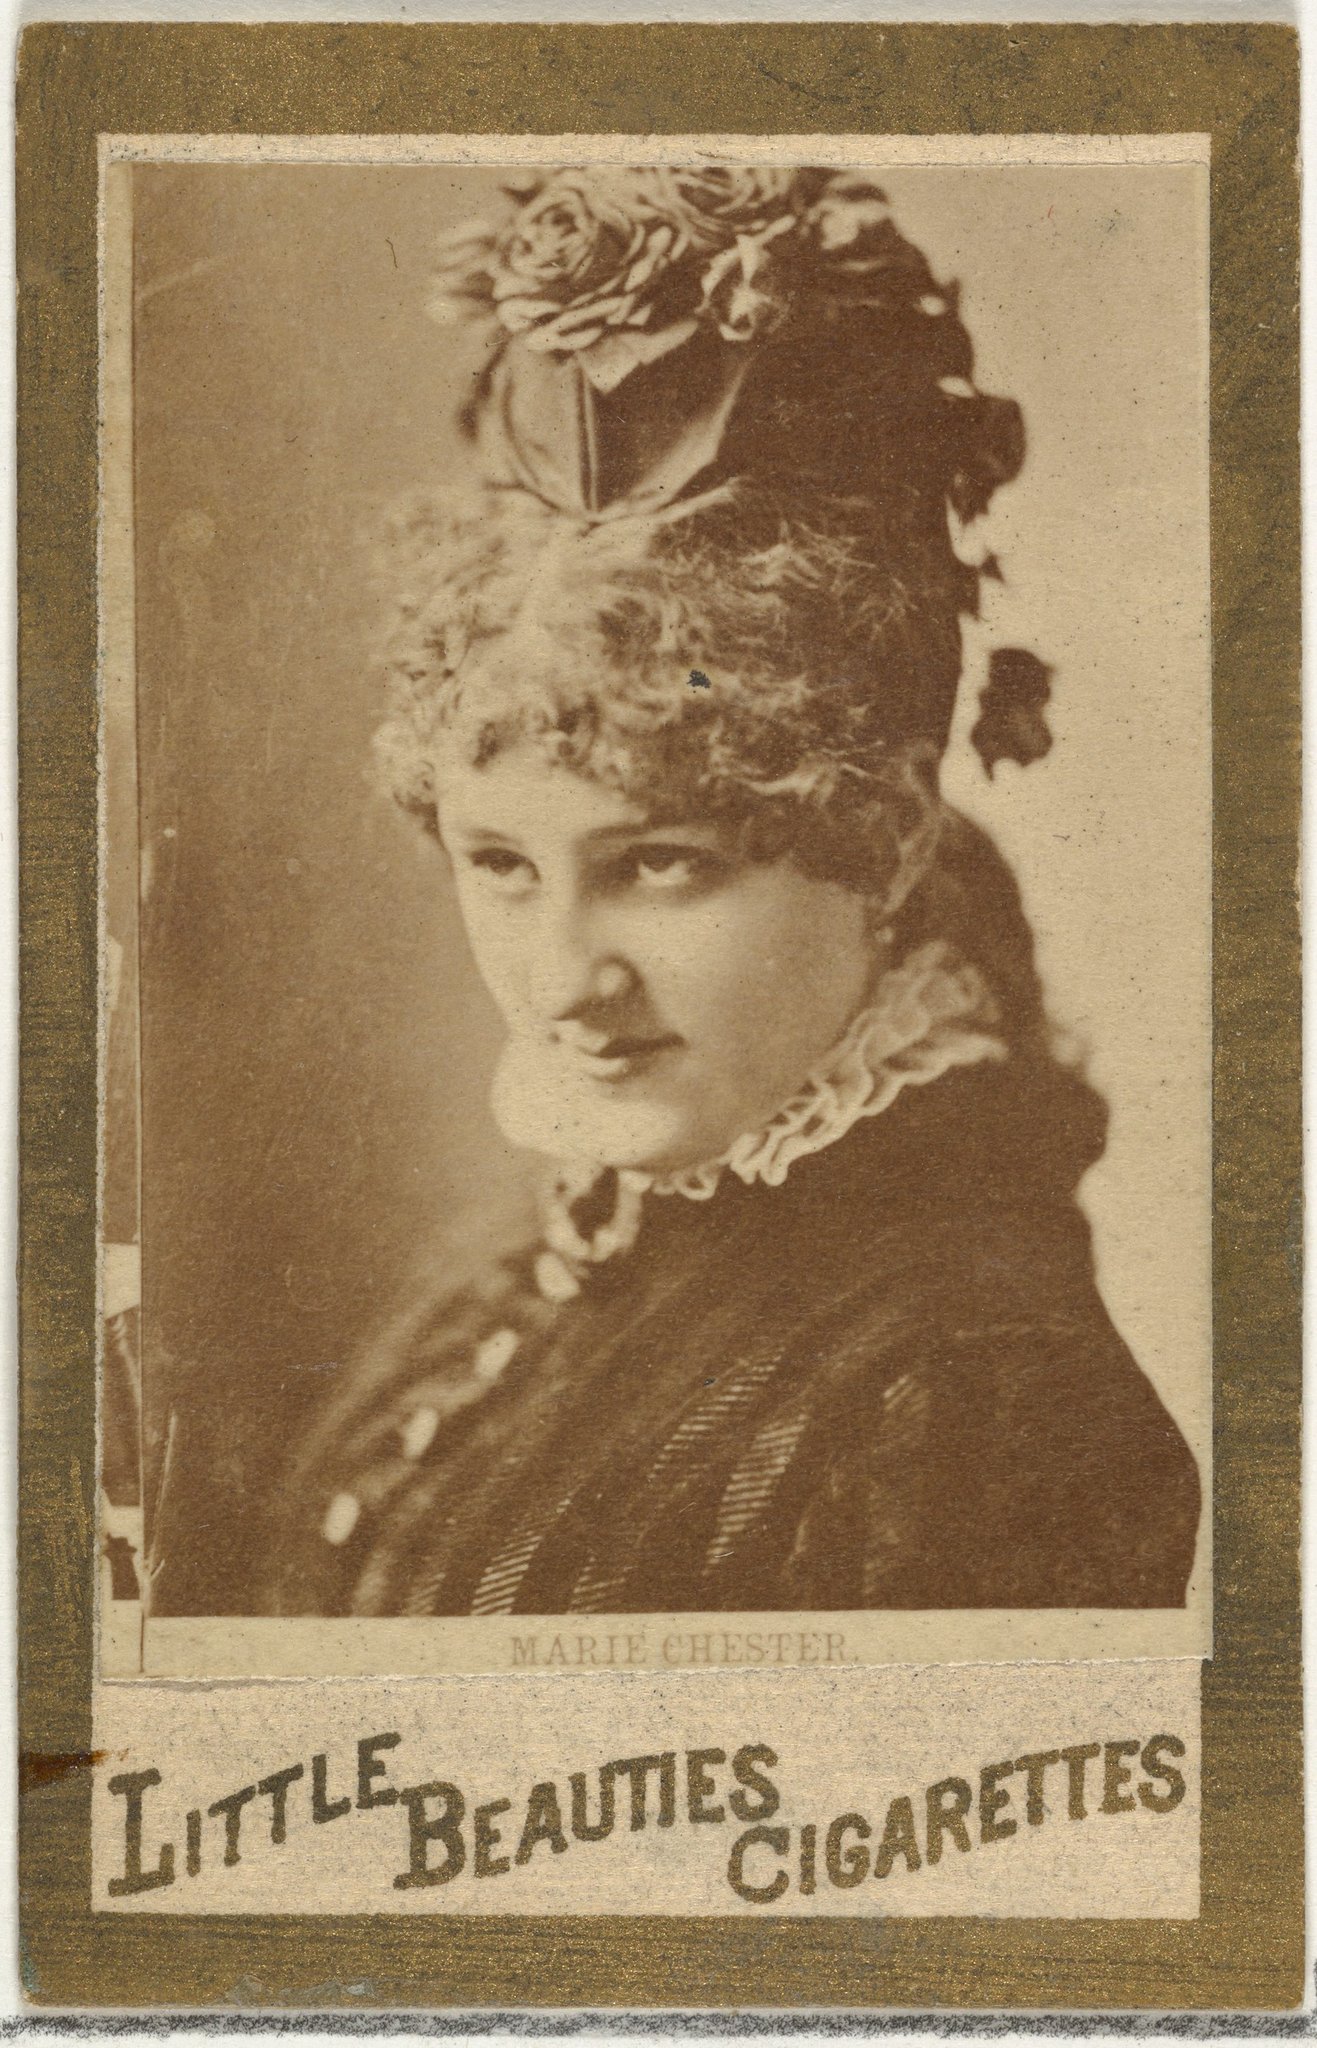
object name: photograph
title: Marie Chester, from the Actresses and Celebrities series (N60, Type 1) promoting Little Beauties Cigarettes for Allen & Ginter brand tobacco products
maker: allen & ginter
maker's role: publisher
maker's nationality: american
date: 1887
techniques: albumen silver print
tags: portraits,women,actresses